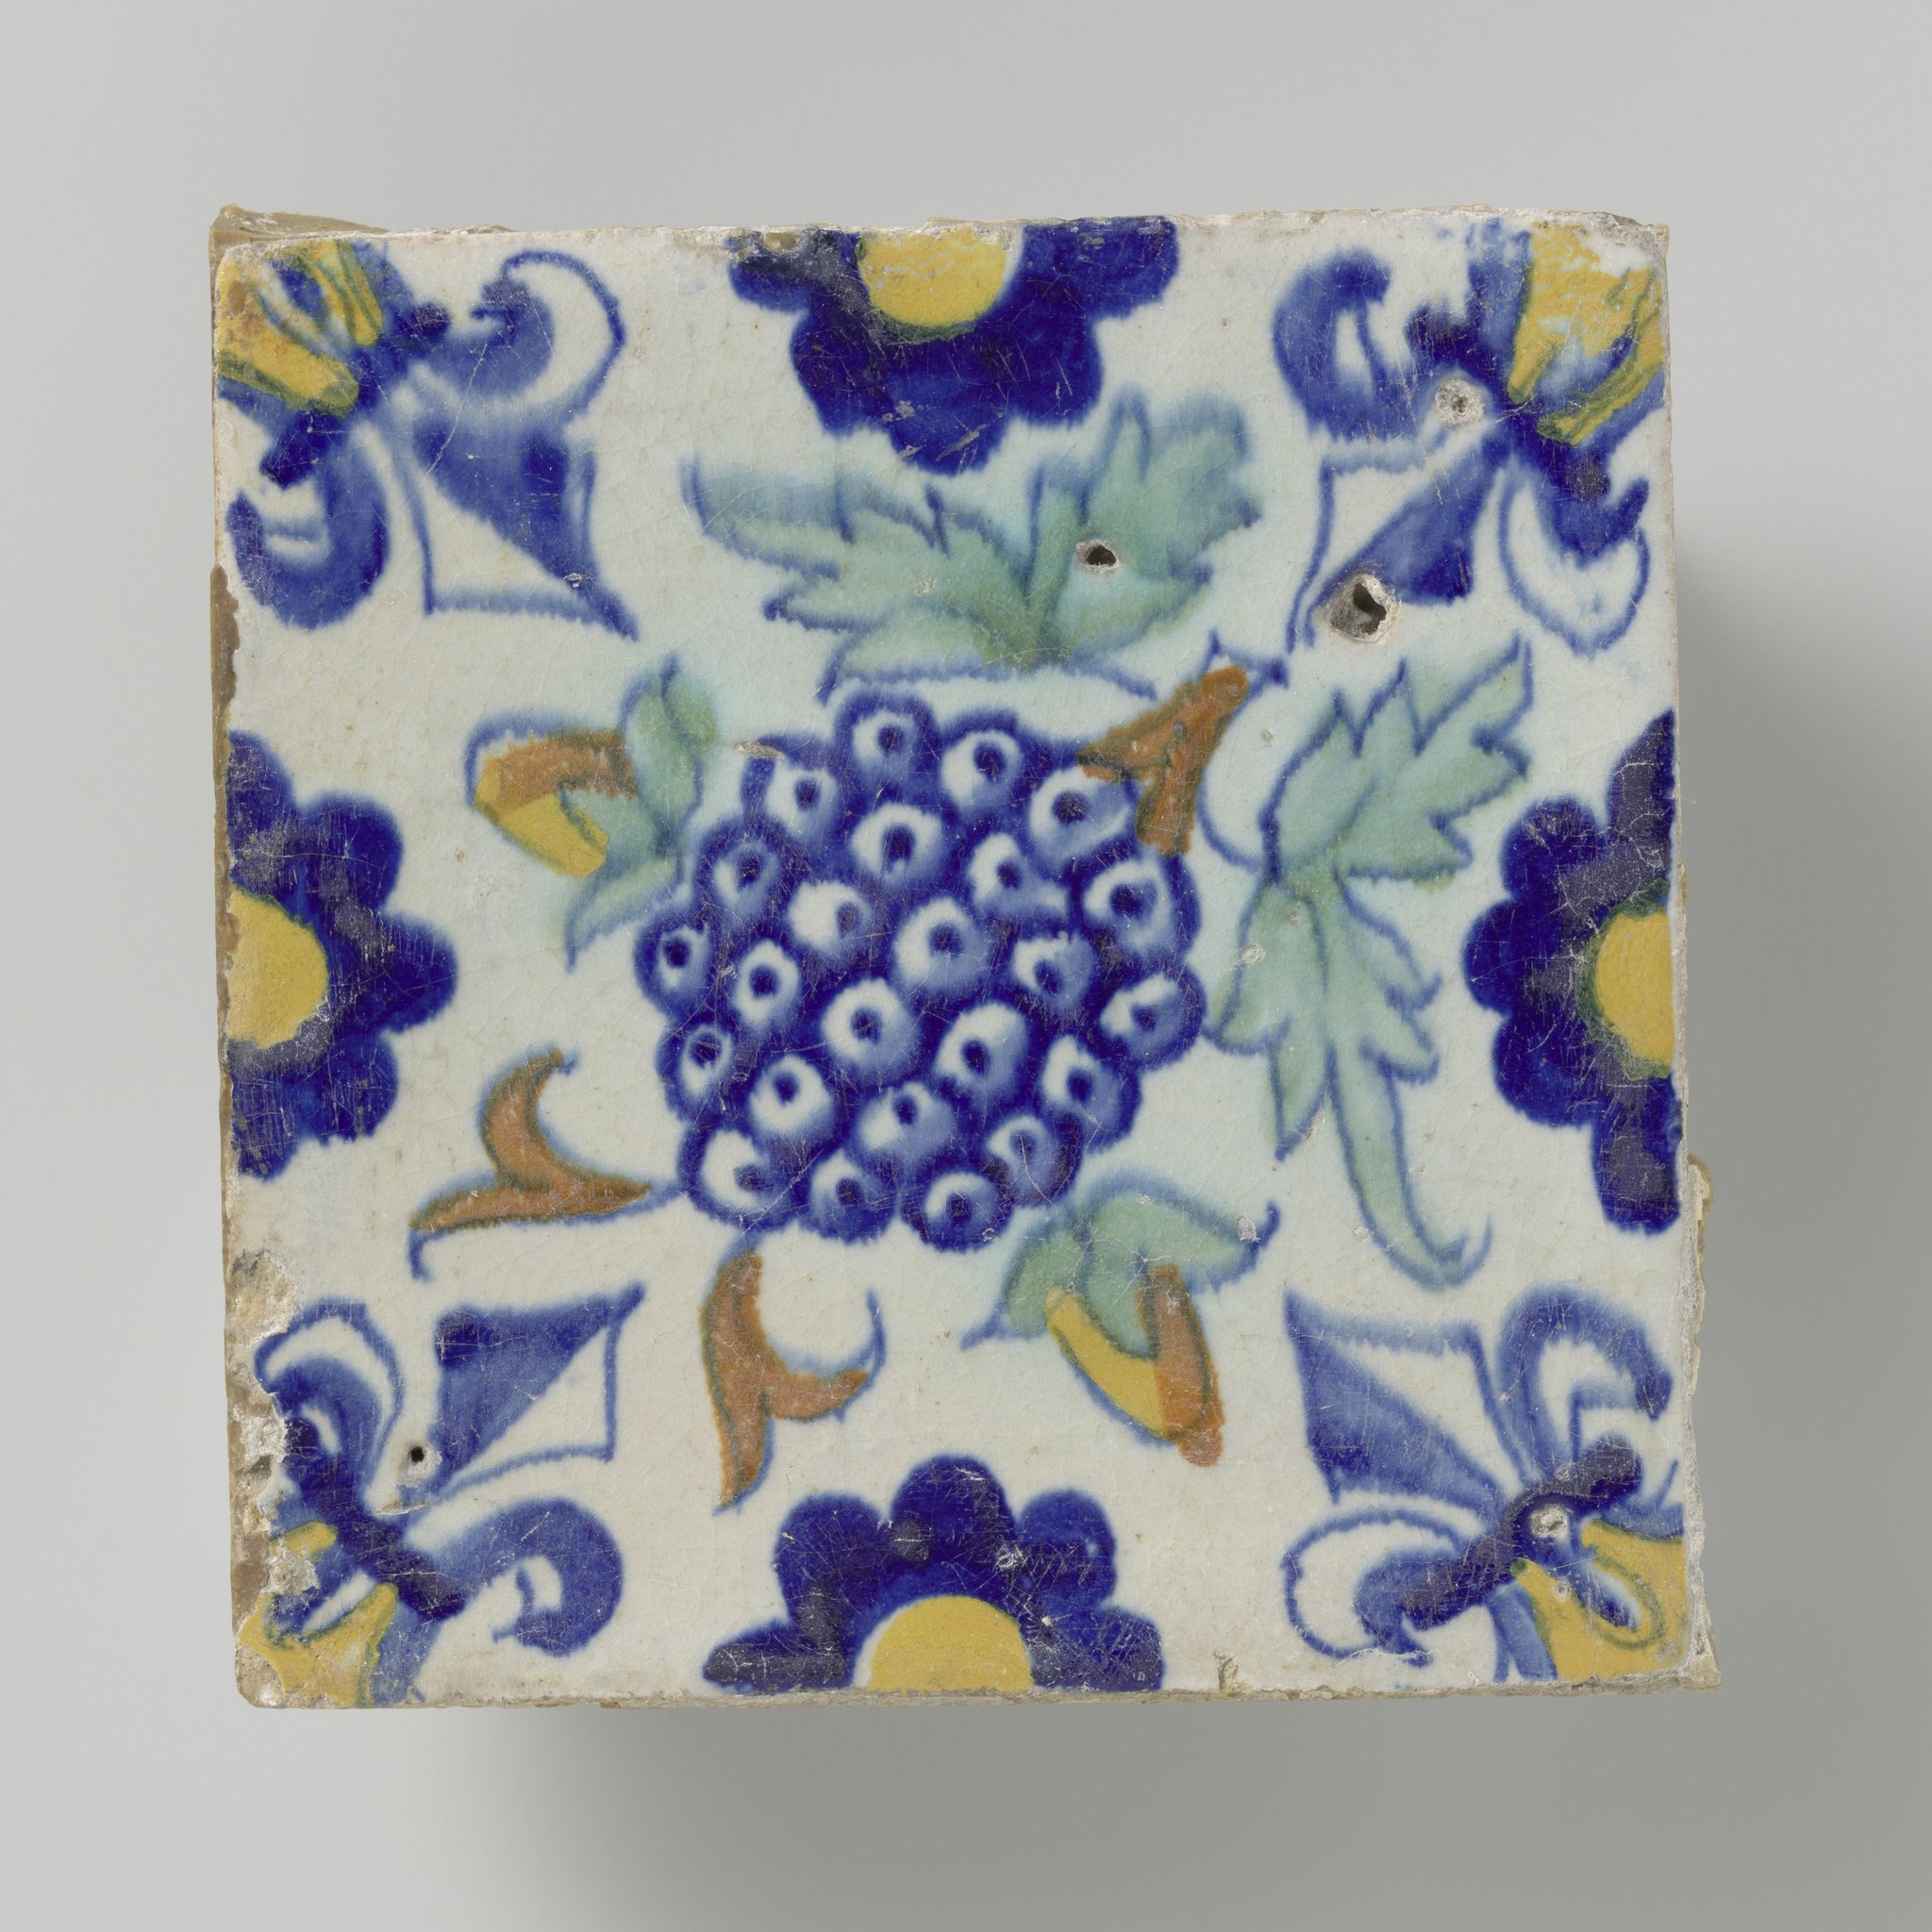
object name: tile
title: Tegel met druiventros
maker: Anonymous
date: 1600-1625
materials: earthenware, glaze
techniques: maiolica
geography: netherlands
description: Tegel met druiventros. Onderdeel van een veld van zestien tegels (4 x 4), zie BK-1955-250-A.